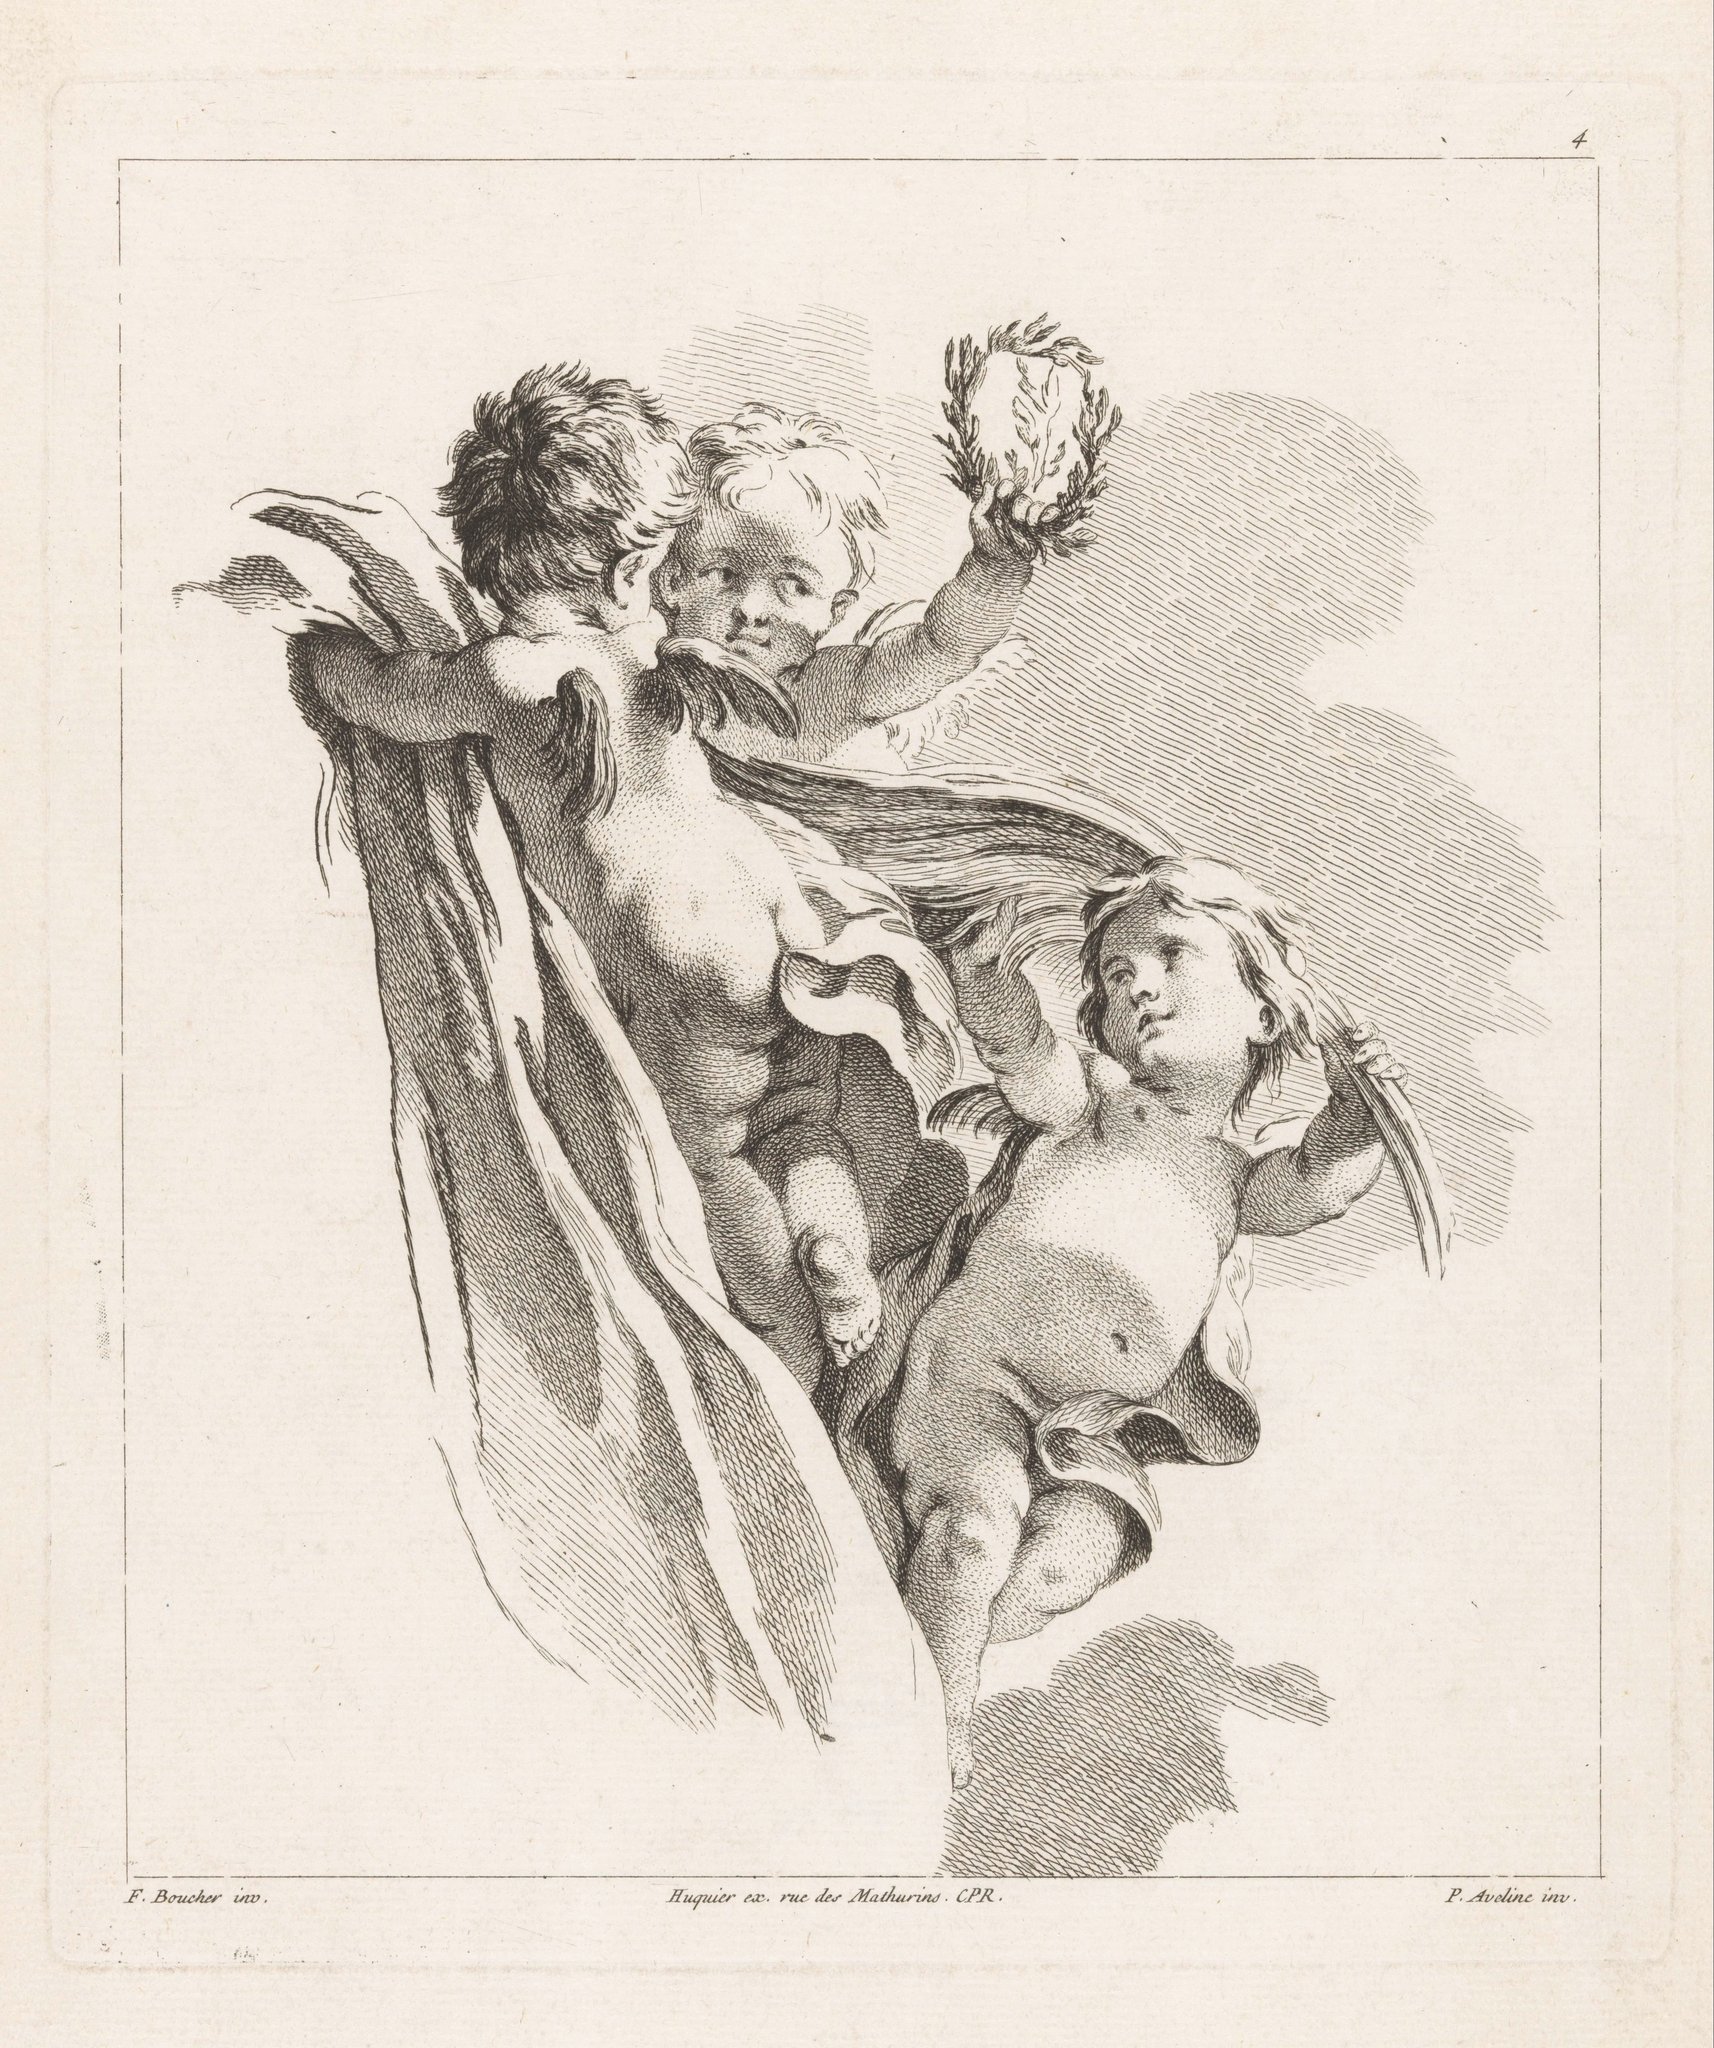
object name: print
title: Putti met lauwerkrans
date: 1713-1760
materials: paper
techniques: engraving, etching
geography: paris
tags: cupids: 'amores', 'amoretti', 'putti'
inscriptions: collector's mark: Lugt 2228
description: Drie putti met een doek en een lauwerkrans.